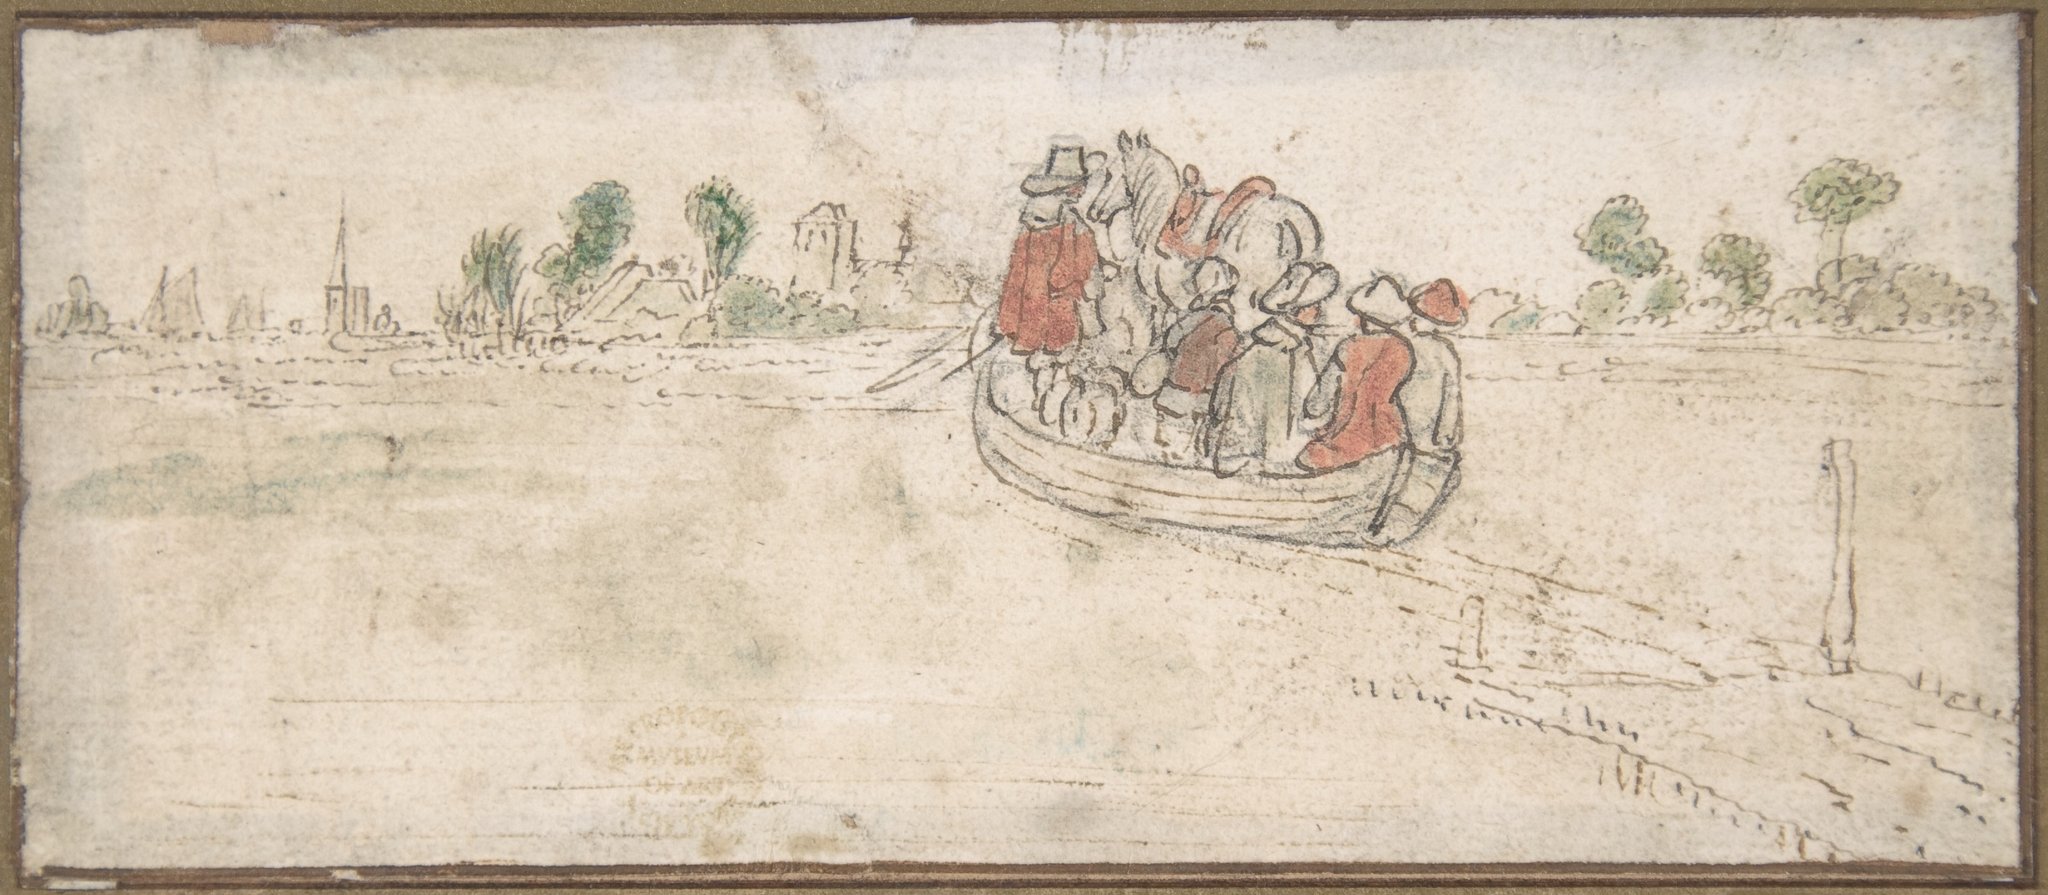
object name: drawing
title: The Ferryboat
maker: hendrick avercamp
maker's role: artist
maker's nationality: dutch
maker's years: 1585-1634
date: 1601-1700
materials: graphite, ink, watercolor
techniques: pen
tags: men,horses,rivers,boats